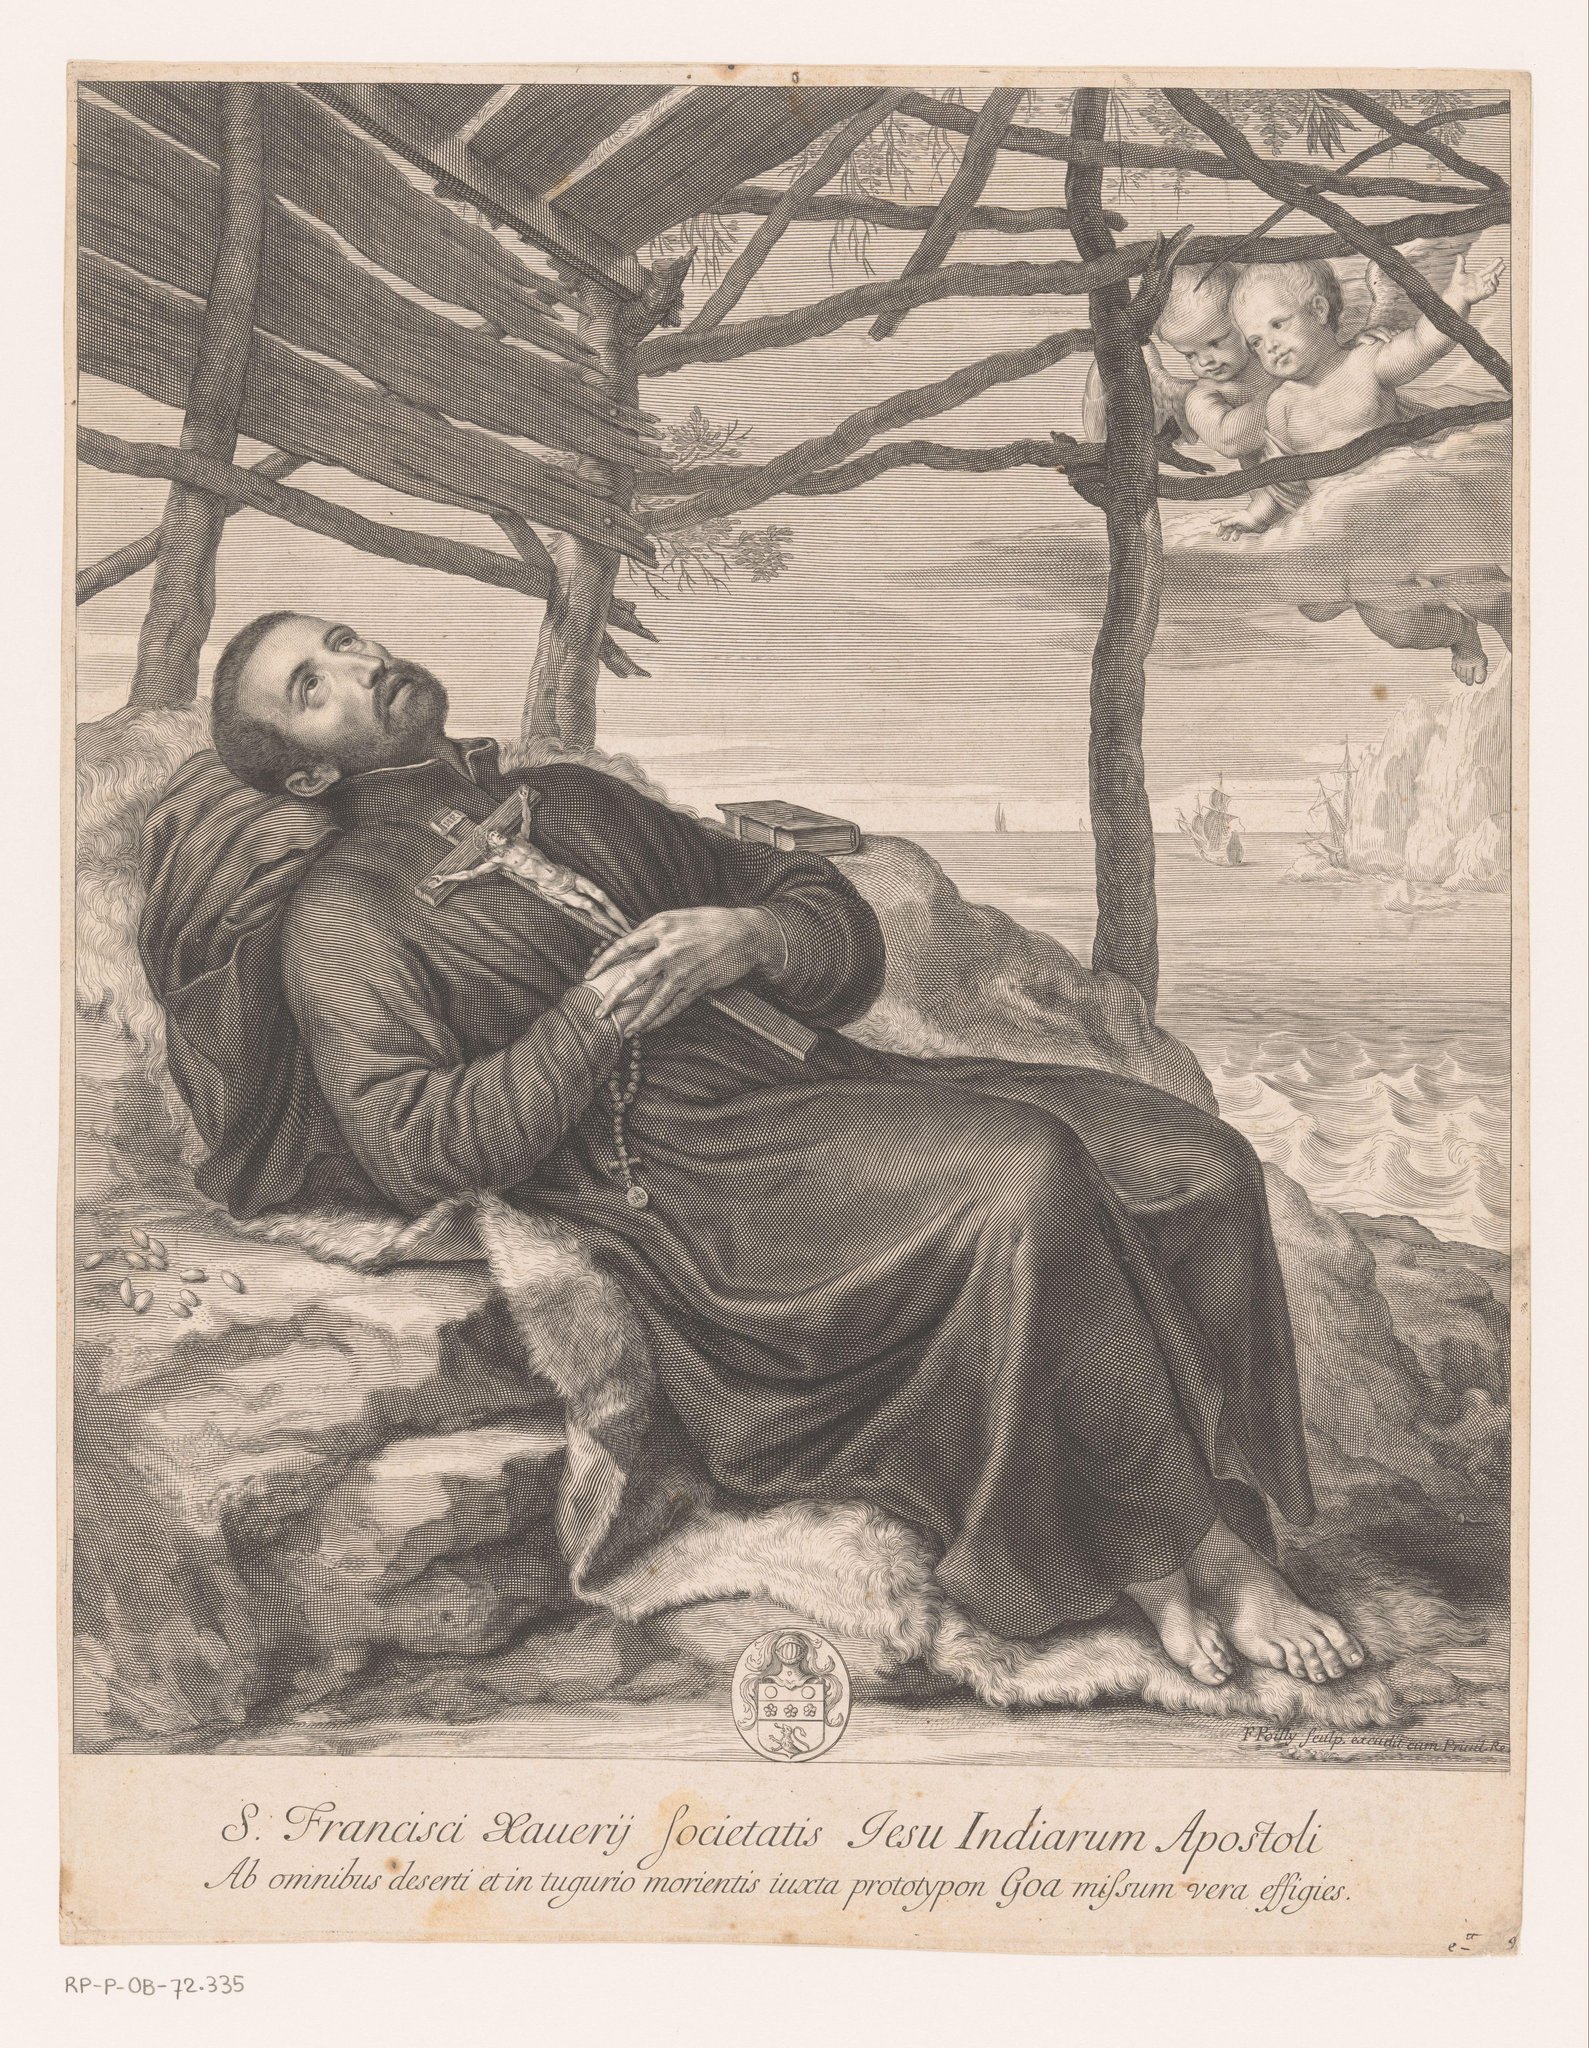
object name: print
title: Heilige Franciscus Xaverius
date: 1648-1681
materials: paper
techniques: engraving, etching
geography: france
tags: the jesuit missionary francis xavier; possible attributes: cross, crucifix, flaming heart, indian, lily, torch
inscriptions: collector's mark: Lugt 240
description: Heilige Franciscus Xaverius liggend onder een overkapping van takken en wrakhout, een crucifix tegen zijn borst gedrukt. Op de achtergrond een zeegezicht met schepen en twee engelen die boven de hut zweven.